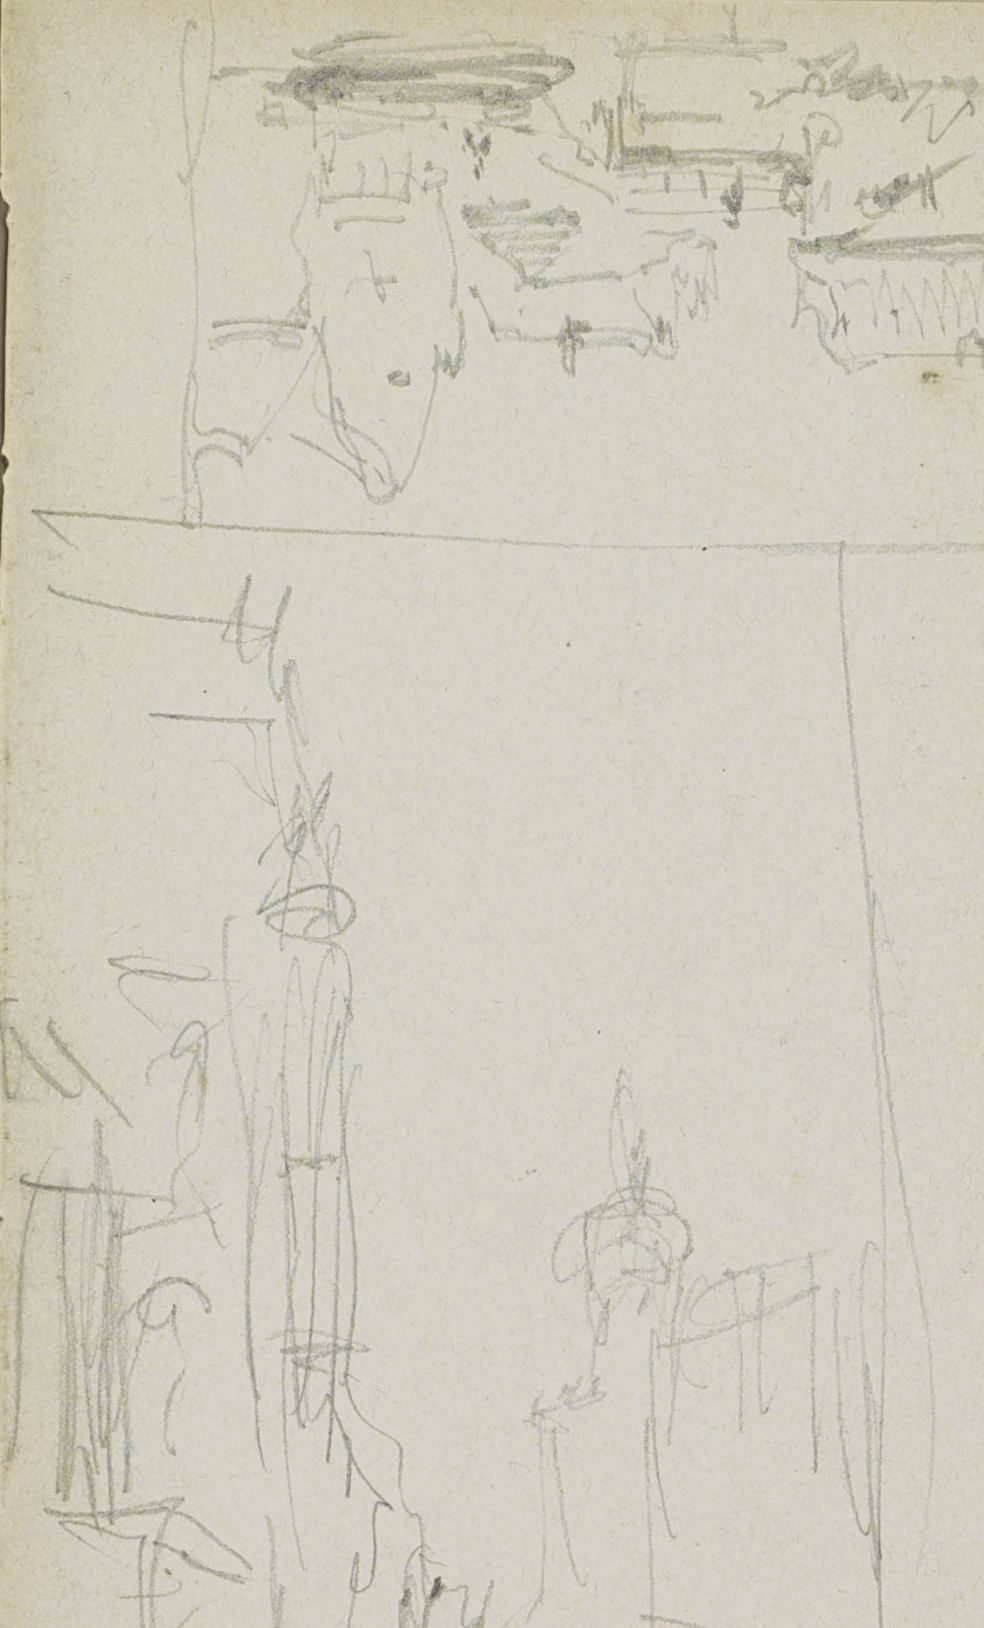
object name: sketchbook leaf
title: Twee stadsgezichten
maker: adrianus eversen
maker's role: draughtsman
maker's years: 1818-1897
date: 1828-1897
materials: paper, pencil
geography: netherlands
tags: urban housing, canals, waters (in city), street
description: Boven een stadsgezicht met een boot op een kanaal. Op de kade staat een figuur. Onder een gezicht op een straat. Blad 63 recto uit een schetsboek met 69 bladen vervaardigd in de omgeving van Delft, Rotterdam, Oudewater en Harlingen.